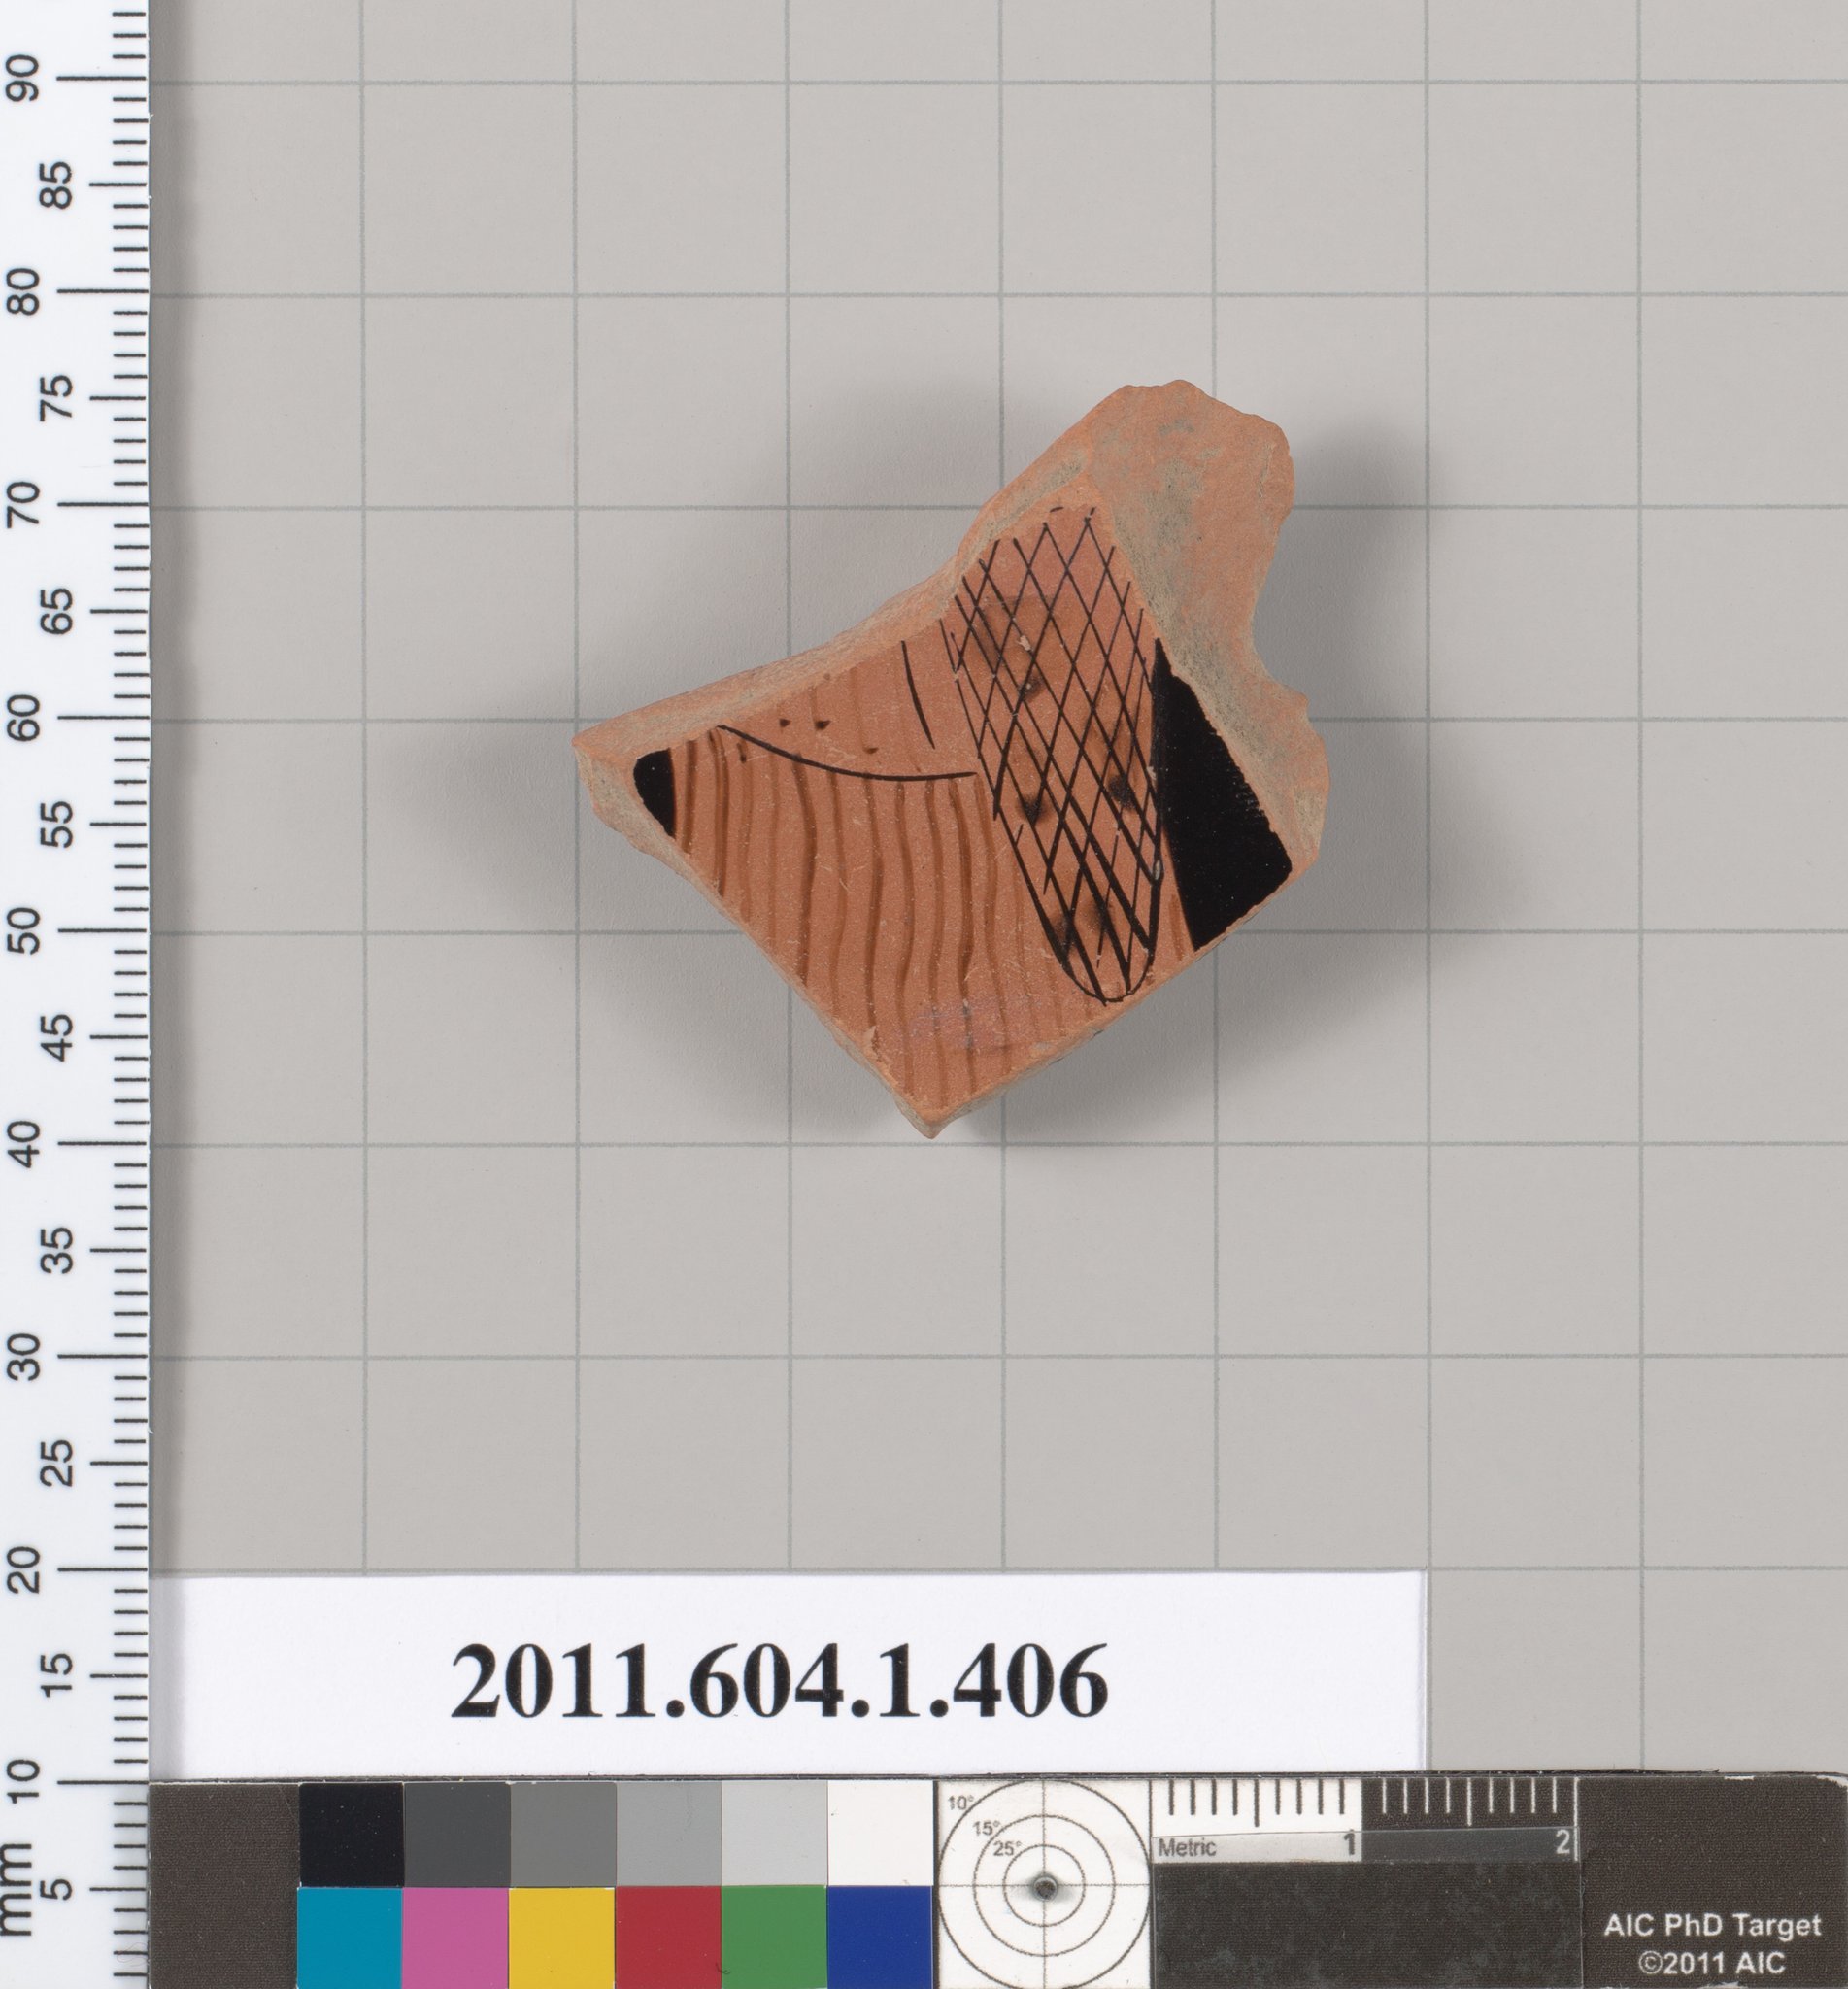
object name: kylix fragment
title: Terracotta fragment of a kylix (drinking cup)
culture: greek, attic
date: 475-451 BCE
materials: terracotta